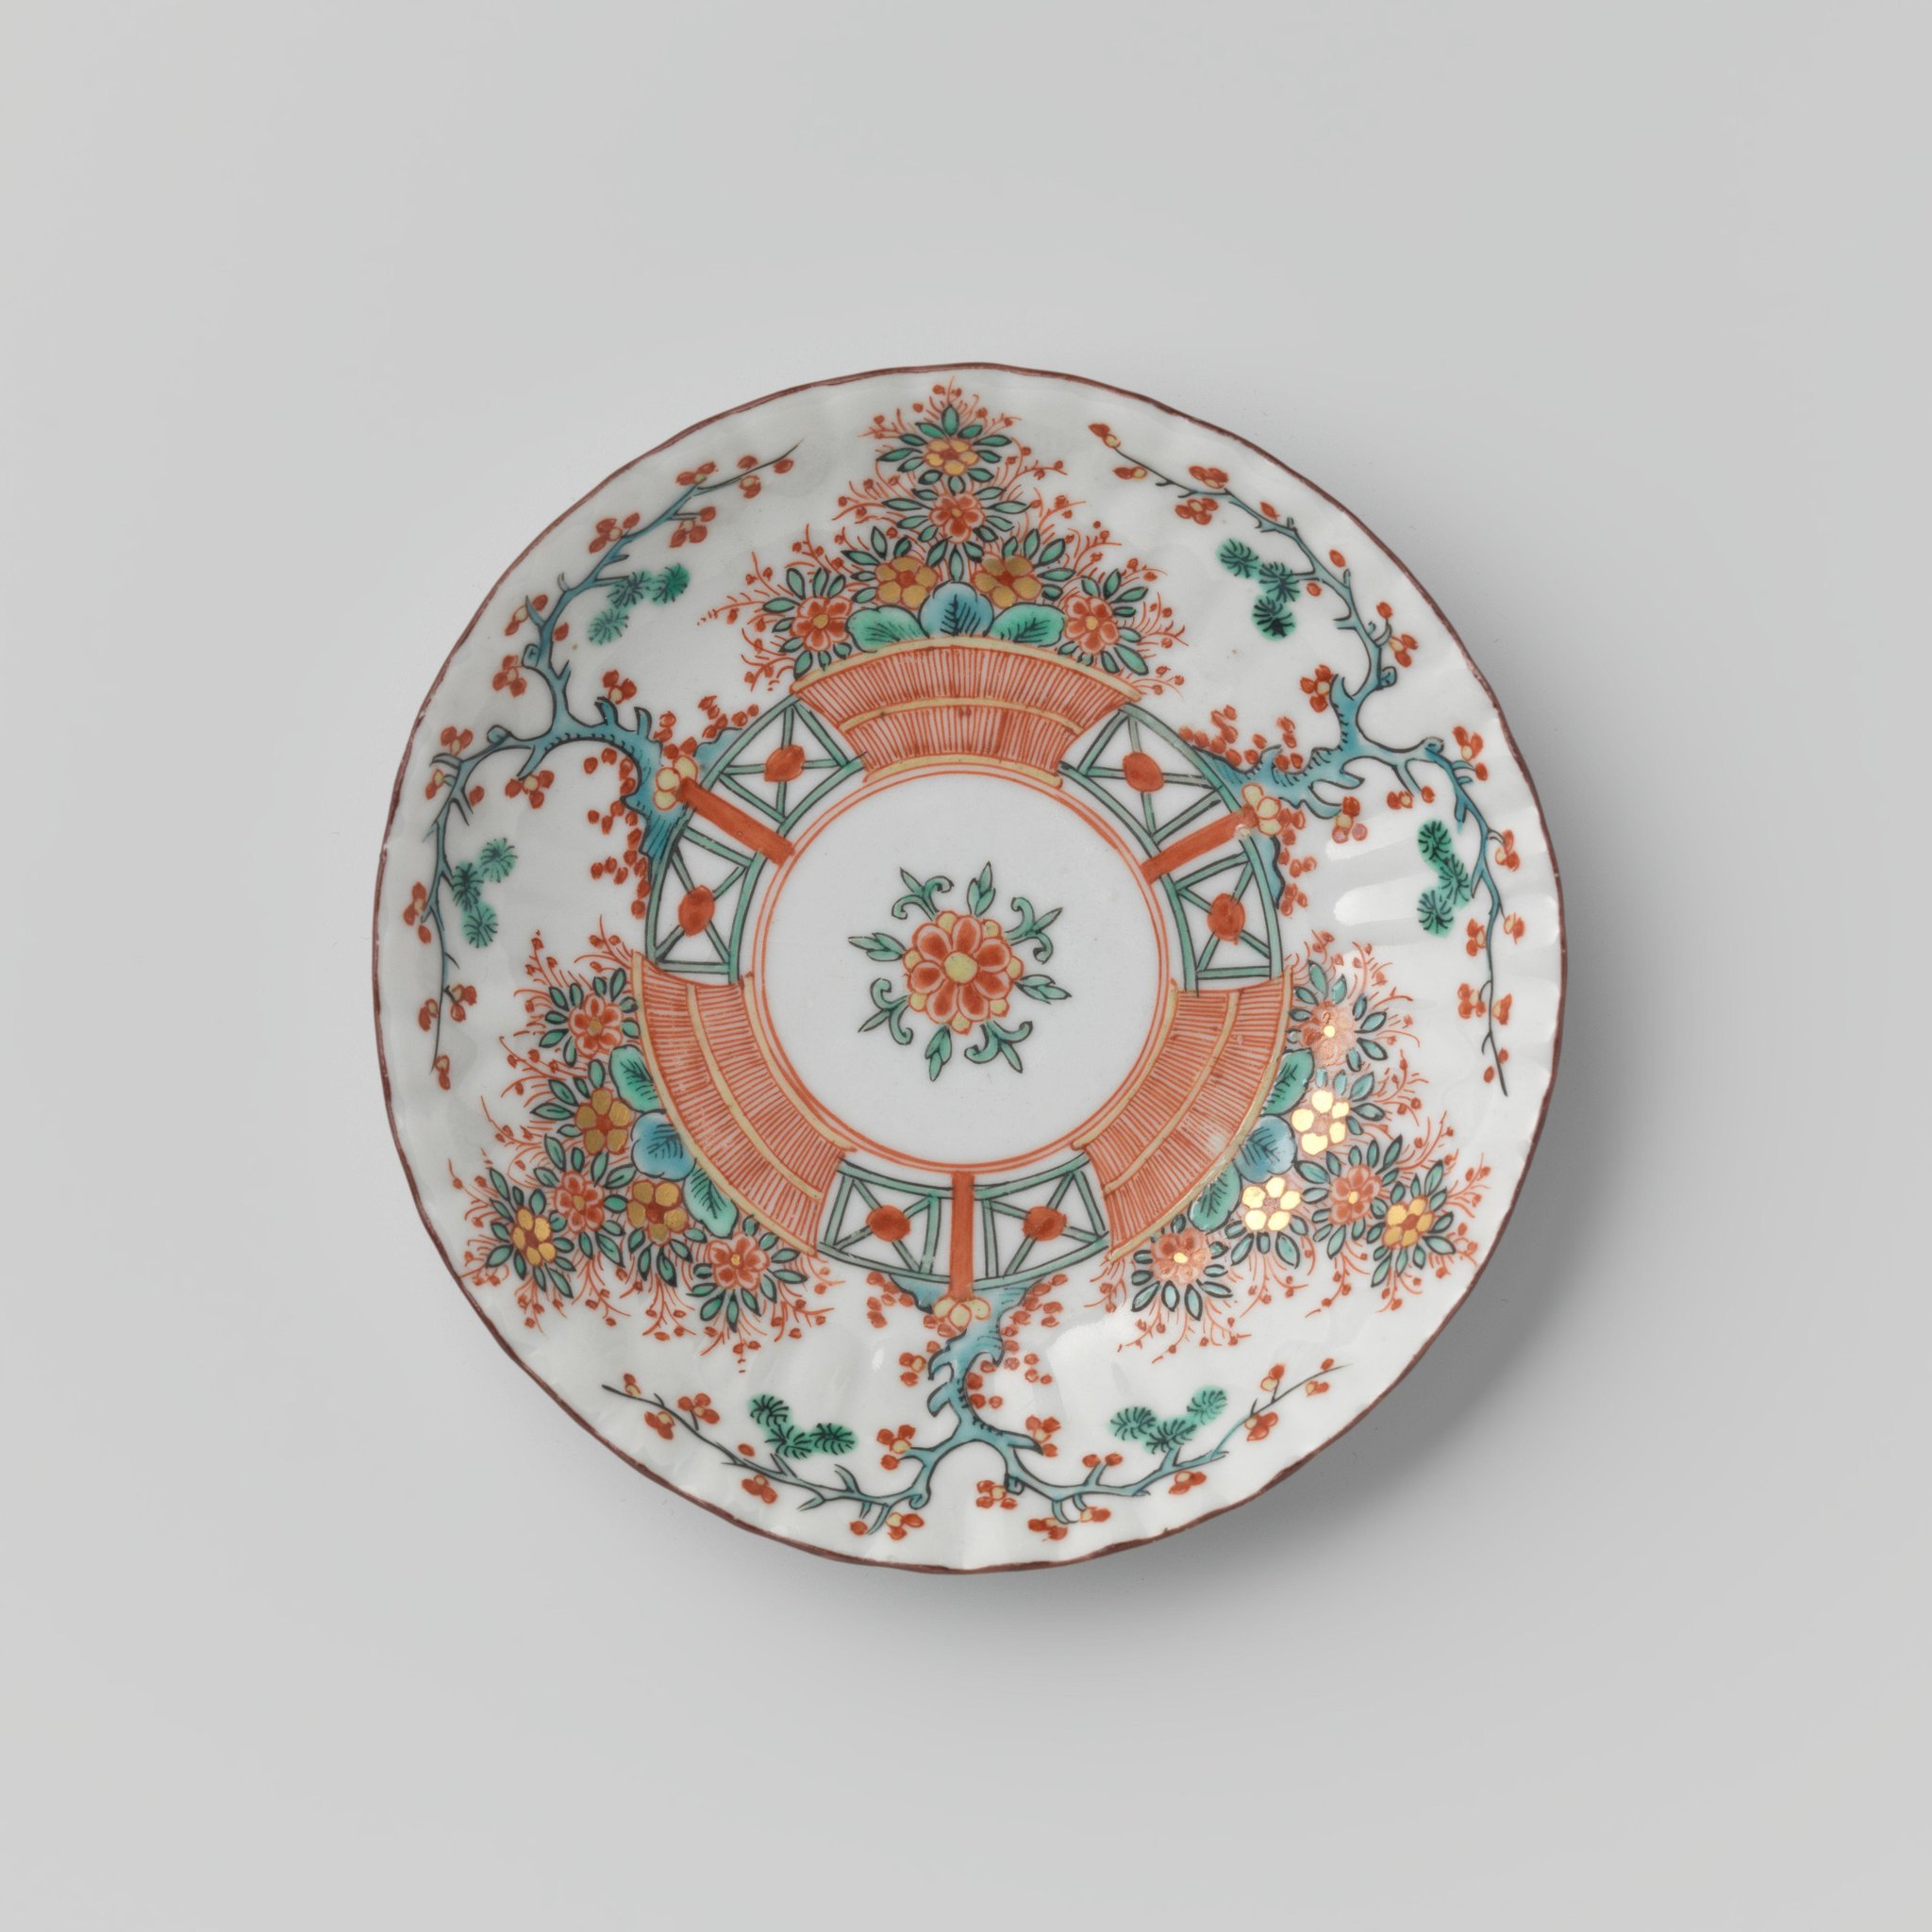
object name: platter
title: Saucer with fluted sides with a flower basket and a tree behind a fence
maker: Anonymous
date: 1700-1749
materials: glaze, gold, paint, porcelain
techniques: firing, gilding, turning, vitrification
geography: china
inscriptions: mark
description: Klokvormige kop en schotel van porselein met een geribde wand, beschilderd op het glazuur in blauw, rood, groen, zwart en goud. Op het plat van de schotel in het centrum een bloemrozet; daaromheen een medaillon waarop afwisselend drie bloemenmanden en driemaal een boom achter een hek. Gemerkt op de onderzijde met een imitatiemerk. In Europa gedecoreerd.